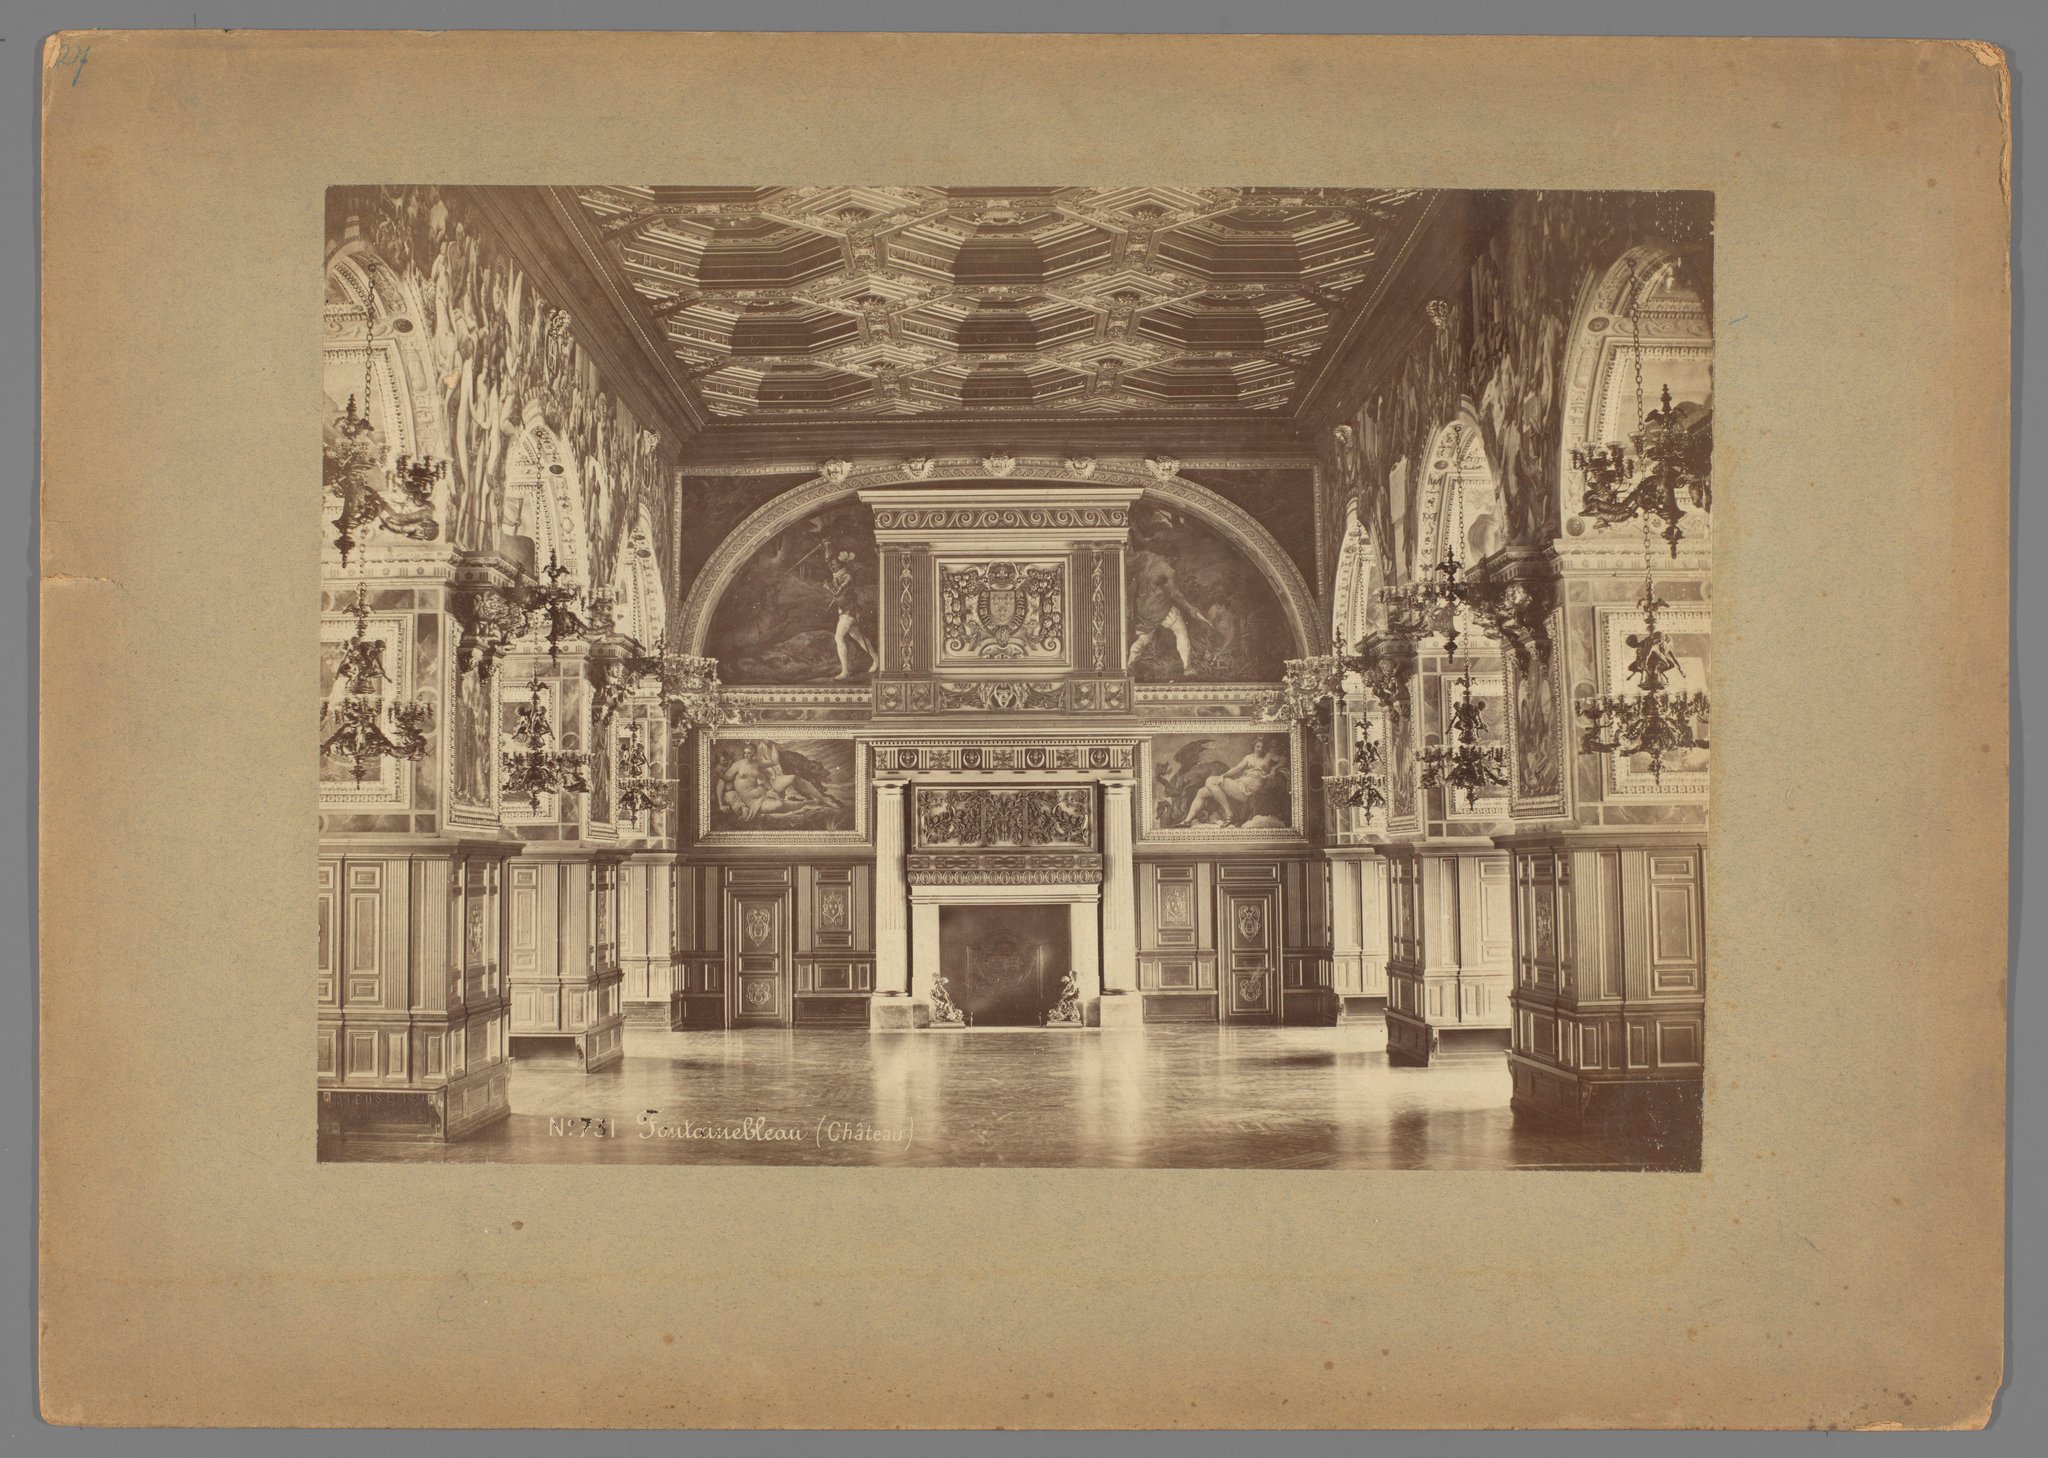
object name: photograph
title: Fontainebleau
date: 1850-1900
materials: cardboard, photographic support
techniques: albumen print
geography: the hague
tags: decorations (interior of the house), ornament ~ candelabrum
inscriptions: inscription: ‘(Château)’, collector's mark: ‘Rijks-normaalschool voor teekenonderwijzers Amsterdam’, number: ‘No. 731’, check stamp: ‘[...]’, workshop stamp: ‘Kunsthandel/ J.A.G. de Leur/ Photograaf- Uitgever/ Huigenspark, 40b,/ Den Haag’